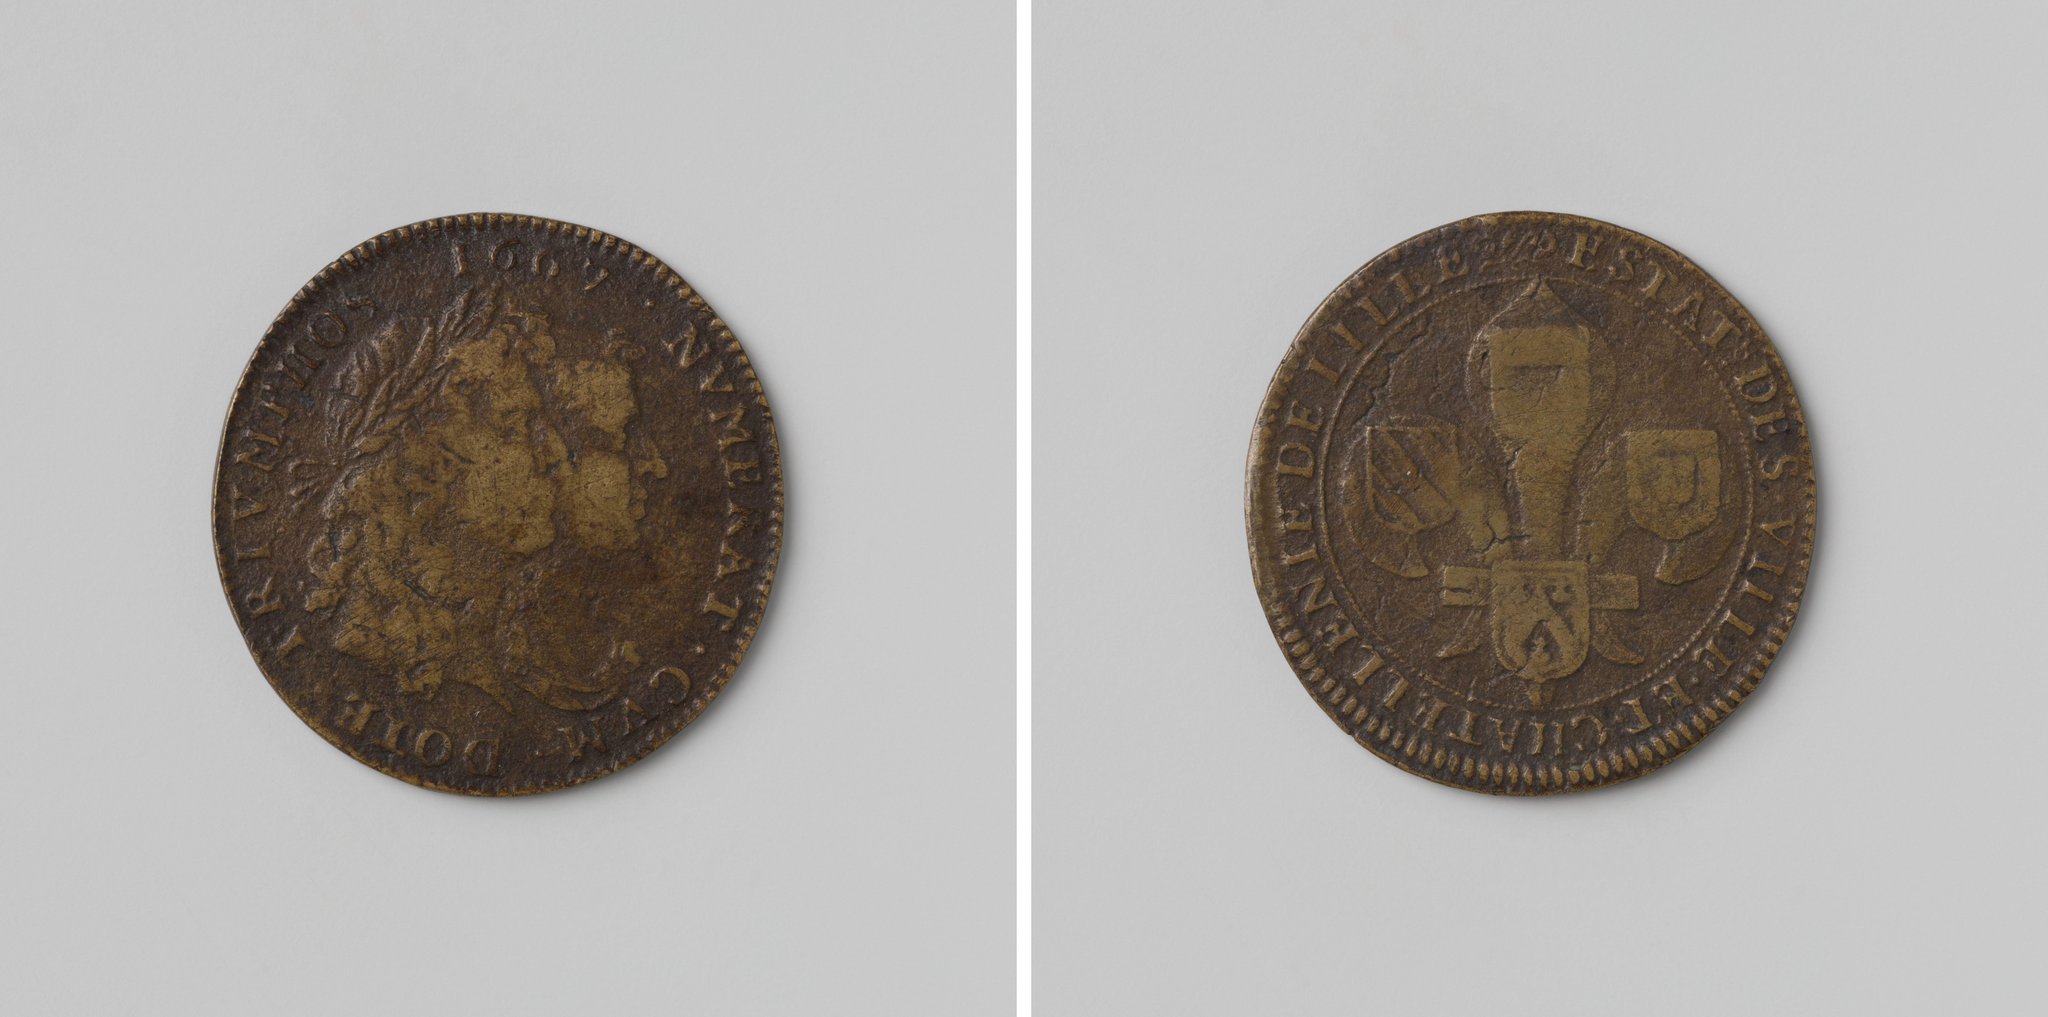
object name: jeton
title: Lodewijk XIV en Maria Theresia, koning en koningin van Frankrijk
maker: Anonymous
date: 1667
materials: copper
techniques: striking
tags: lodewijk xiv (koning van frankrijk), maria theresia (koningin van frankrijk), lille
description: Koperen penning. Voorzijde: borststuk man met lauwerkrans en vrouw binnen omschrift. Keerzijde: lelie, bekleed met vier wapenschilden binnen omschrift.